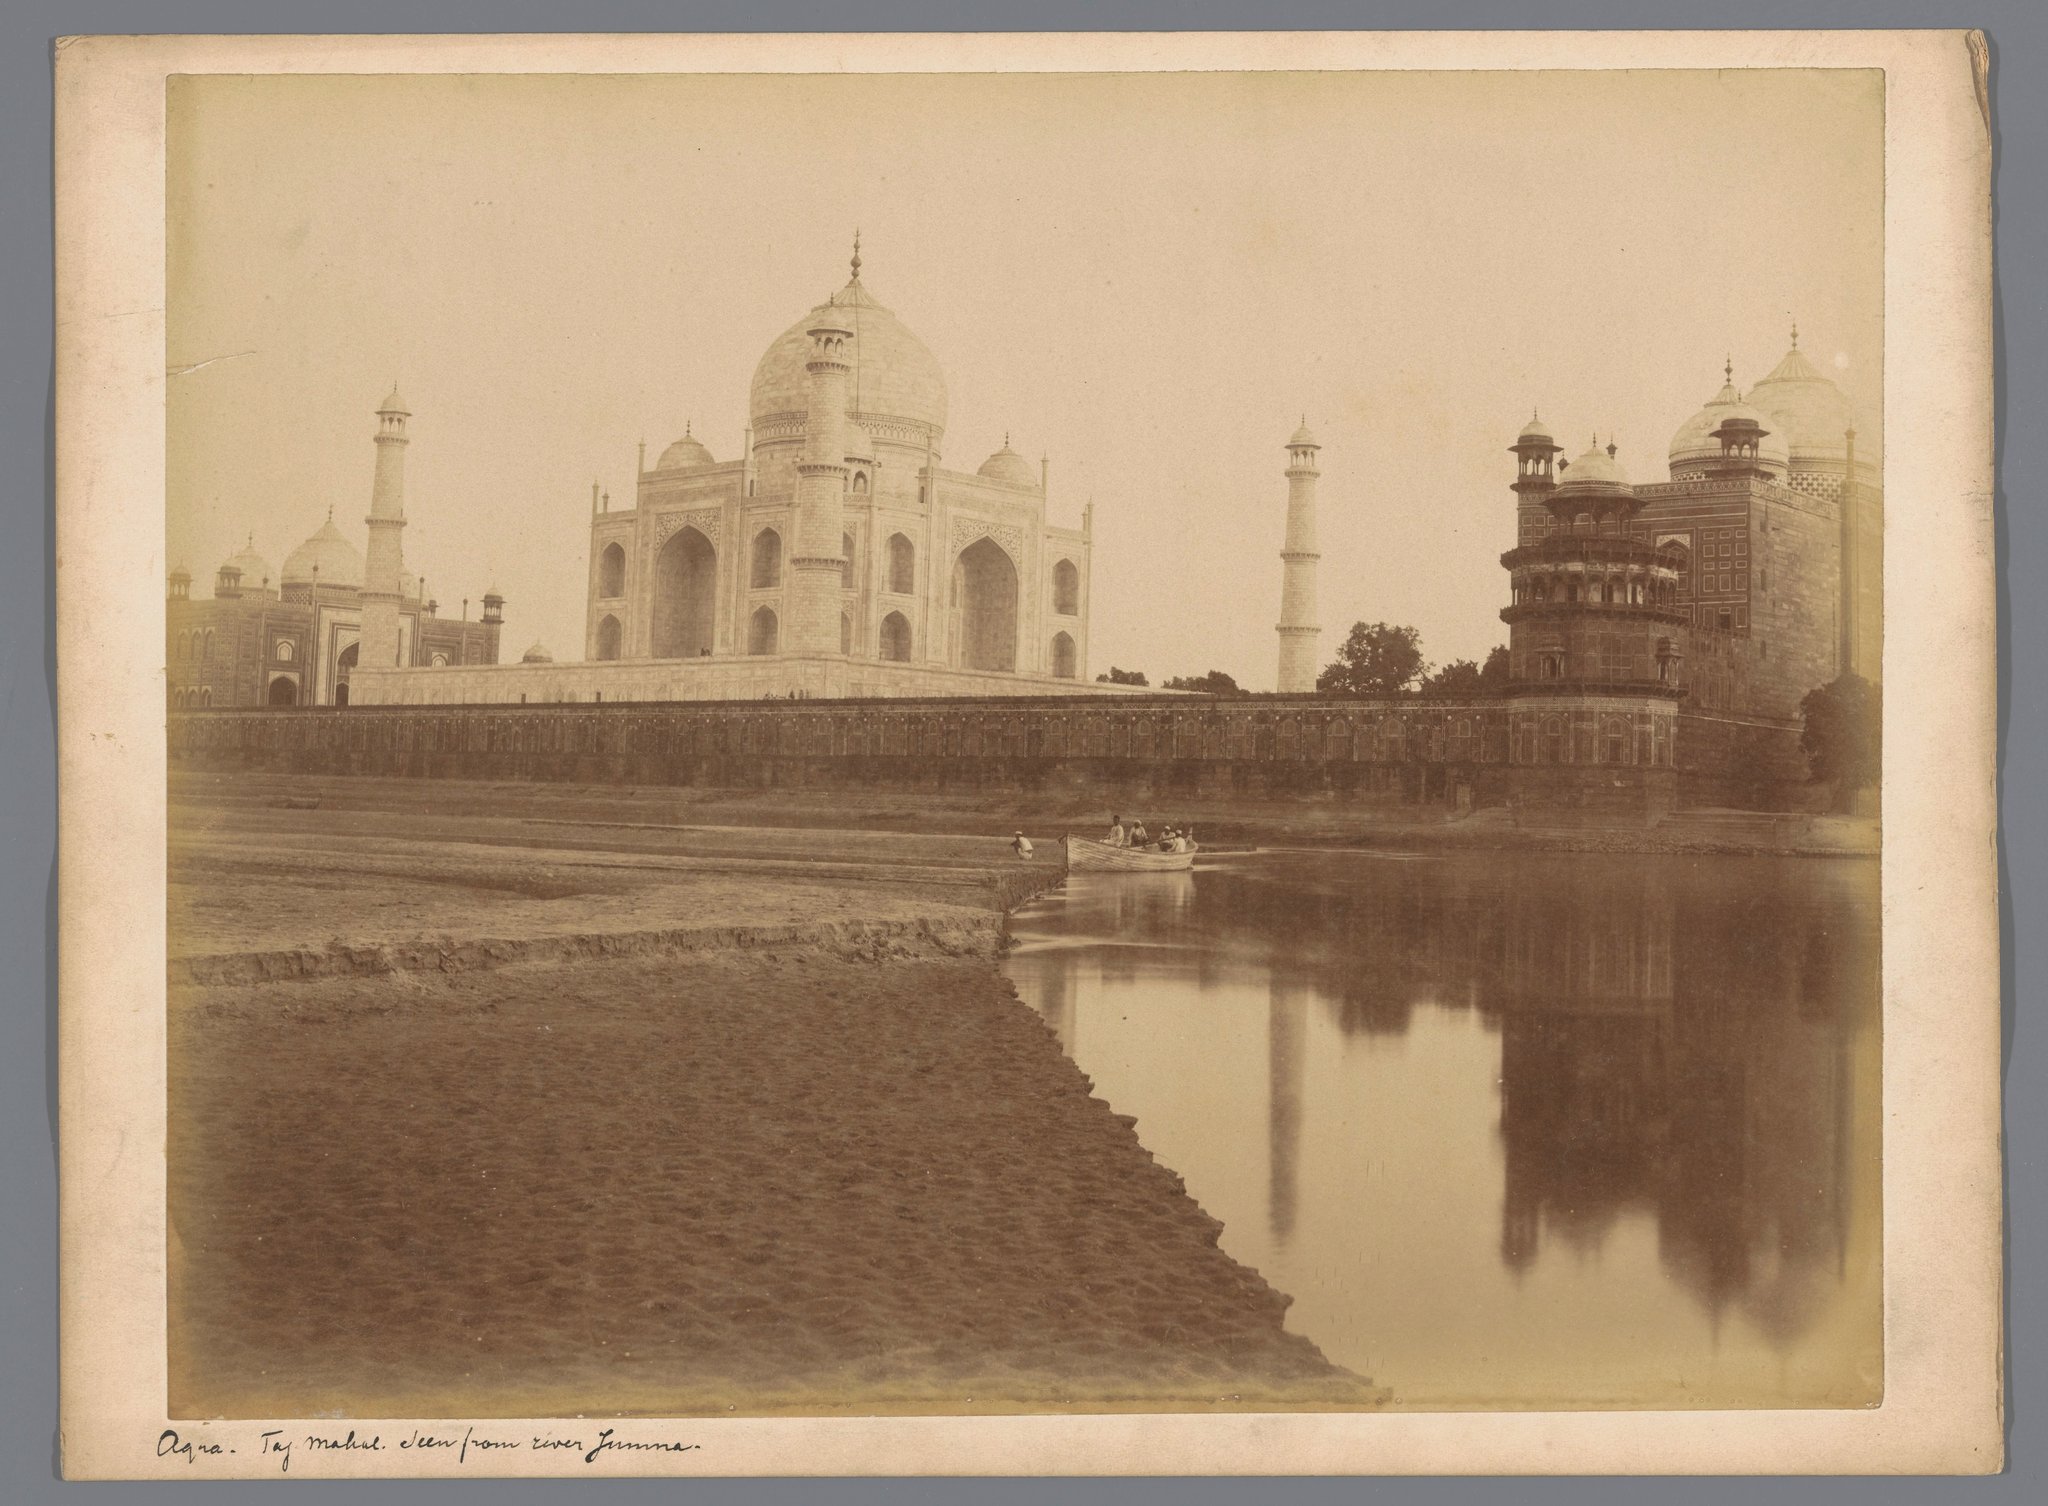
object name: photograph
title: View of the Taj Mahal from the Yamuna river, Agra, Uttar Pradesh, India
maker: Anonymous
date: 1865-1890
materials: cardboard, paper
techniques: albumen print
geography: agra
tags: river, mausoleum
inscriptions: number: ‘20’, title: ‘Agra. Taj Mahal. Seen from river Jumna’